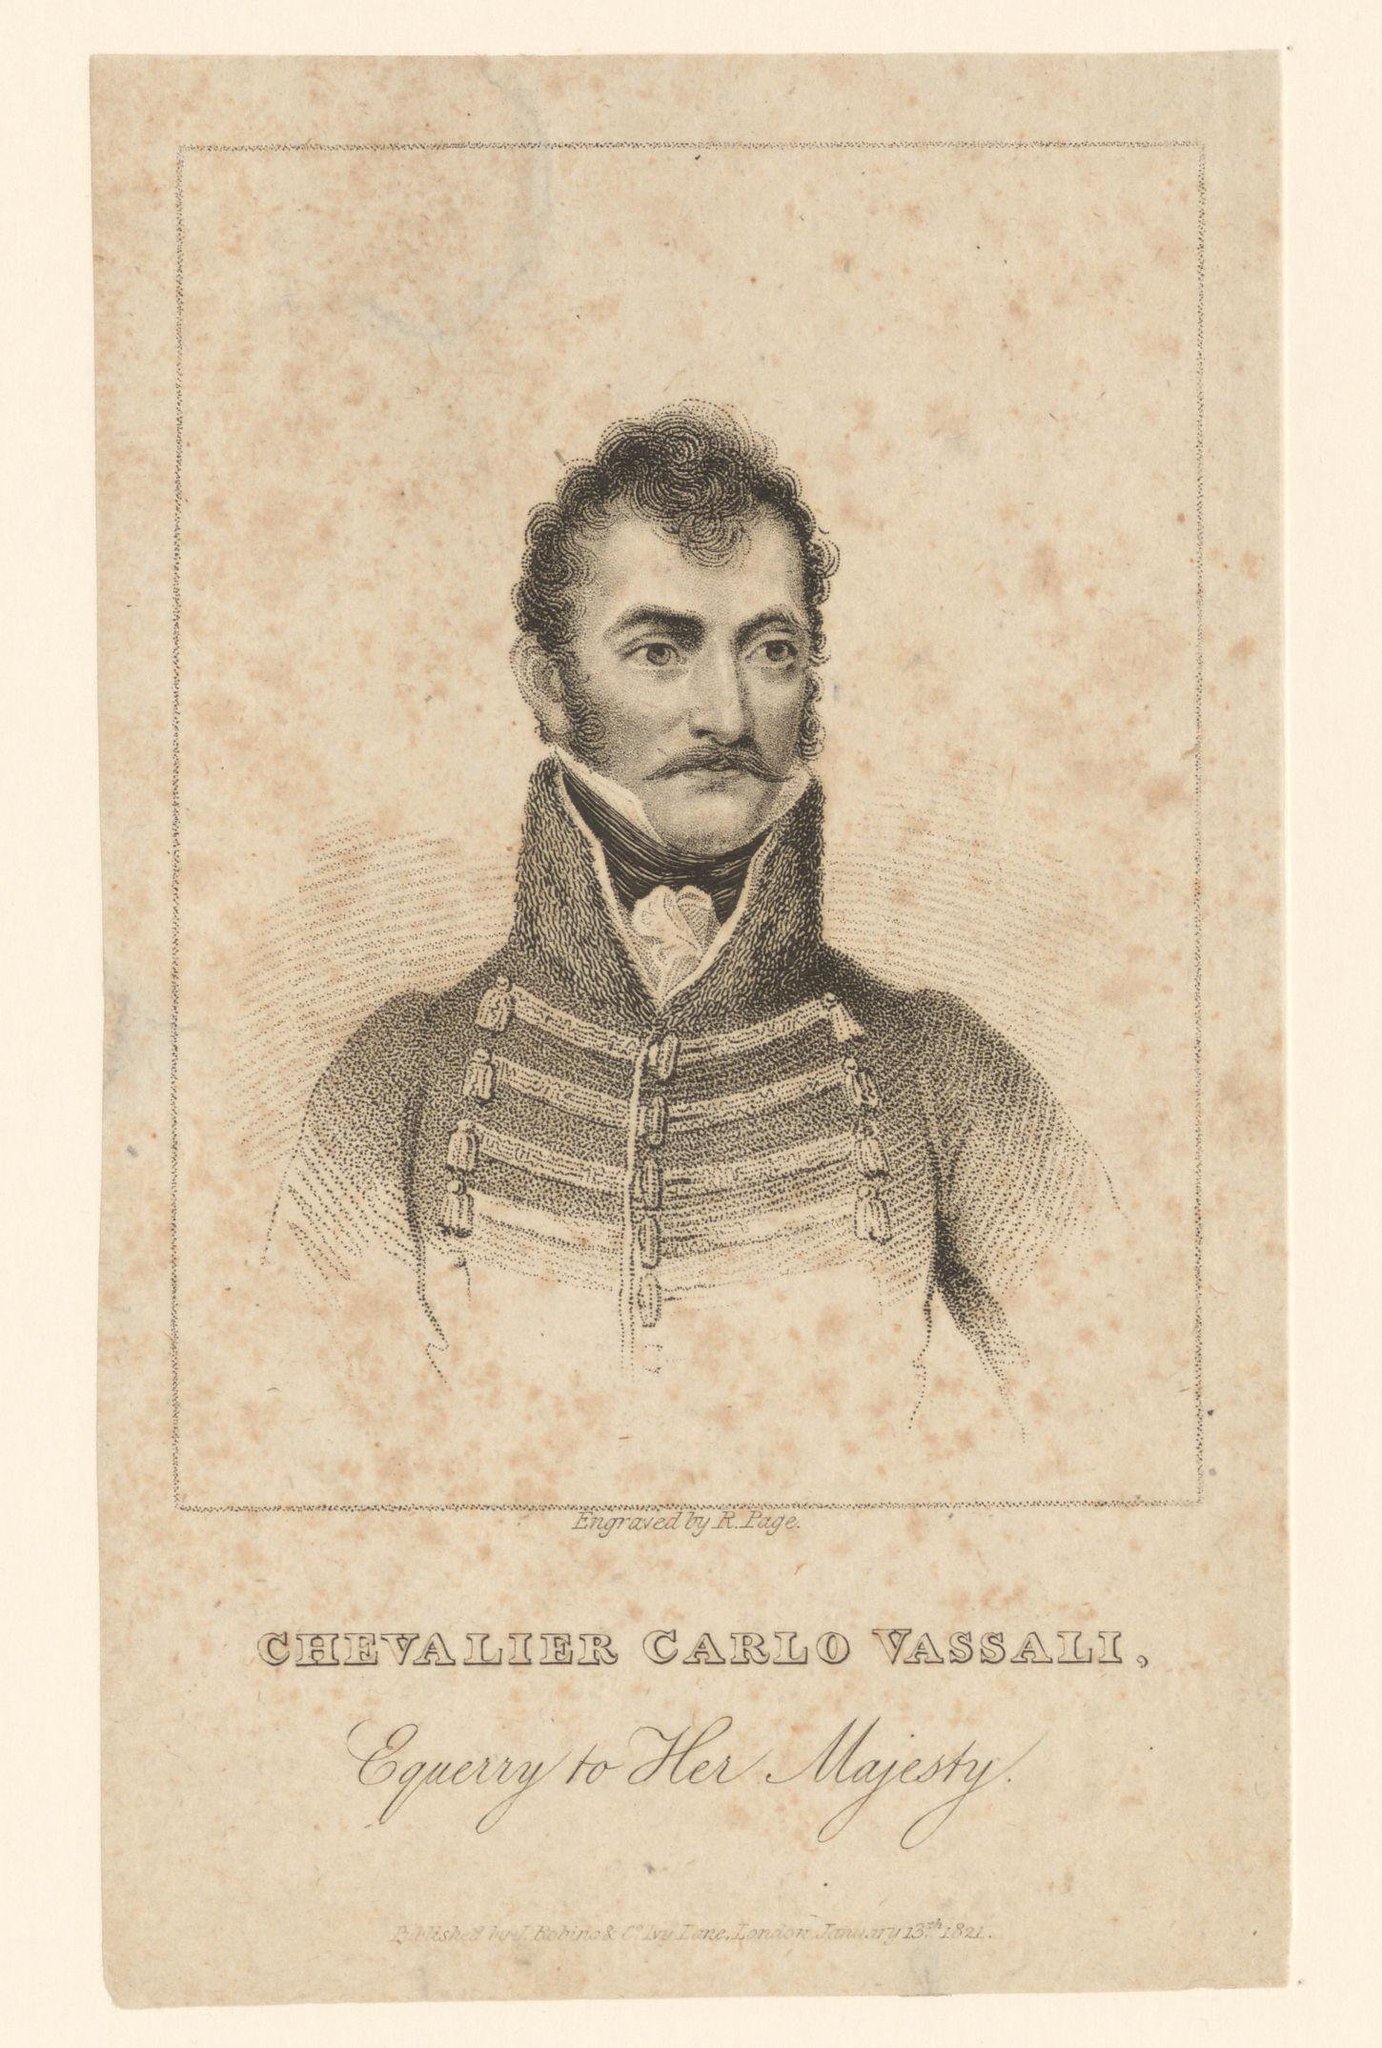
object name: print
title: Portret van Carlo Vassali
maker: r. page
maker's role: print maker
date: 1821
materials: paper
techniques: etching, roulette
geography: london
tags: historical persons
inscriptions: collector's mark: Lugt 2228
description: Prent uit: Nightingale, Joseph. Memoirs of the Last Days of her late most Gracious Majesty Caroline (...). Londen: James Robins & Co., 1822.